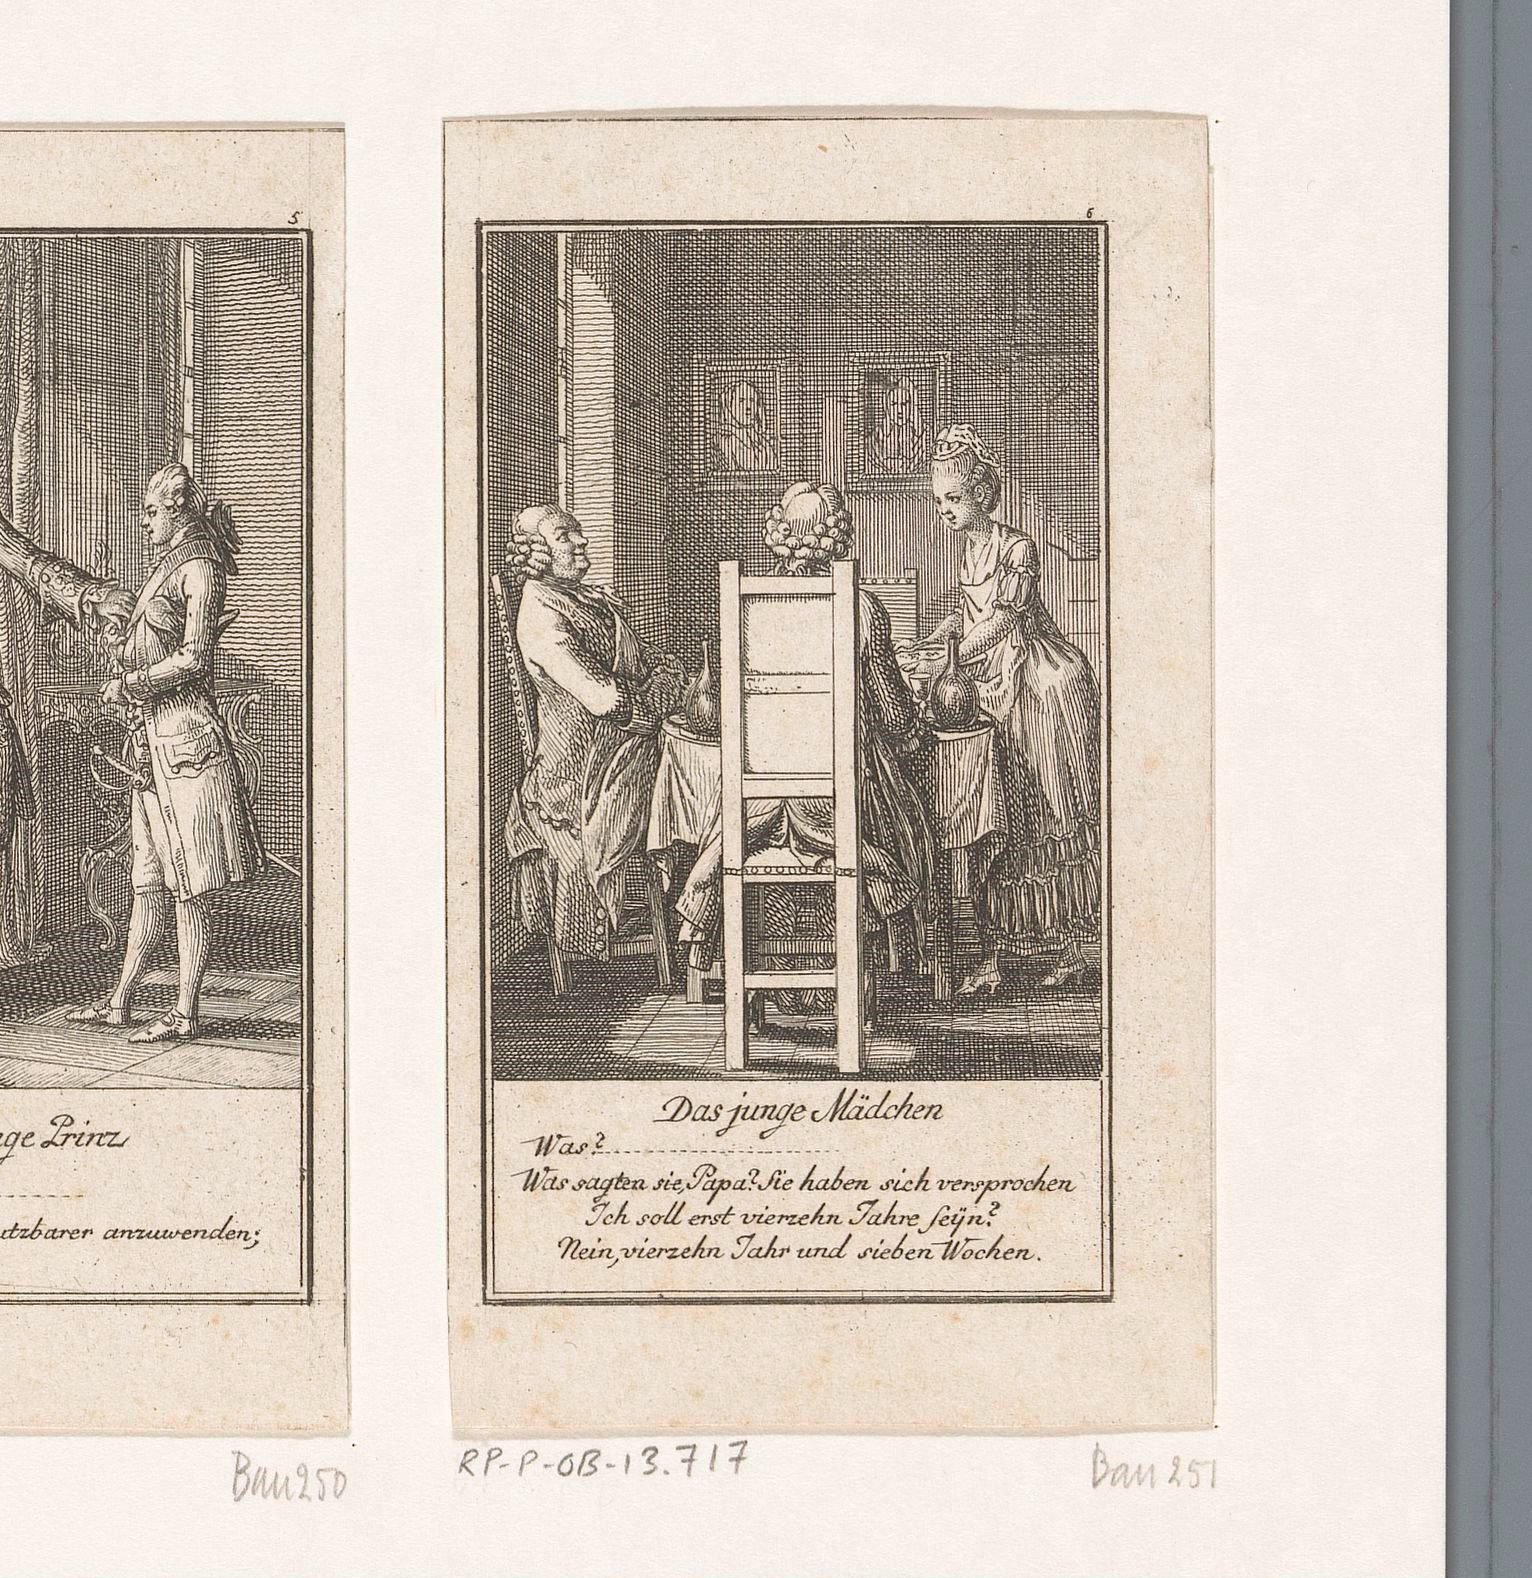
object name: print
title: Das junge Mädchen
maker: daniel nikolaus chodowiecki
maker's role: draughtsman, print maker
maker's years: 1726-1801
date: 1775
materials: paper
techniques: etching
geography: berlin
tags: father and daughter(s) (family group), literature, proposal, declaration of love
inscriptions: collector's mark: Lugt 2228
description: Een man krijgt een huwelijkskandidaat op bezoek die om de hand van zijn dochter vraagt. Hij antwoordt hem dat zijn dochter pas veertien jaar is. Daarop komt de dochter het vertrekt binnen en verklaart dat haar vader liegt en dat ze al veertien jaar en zeven weken oud is. Hierop gaat haar vader akkoord met het huwelijk. Rechtsboven genummerd: 6.